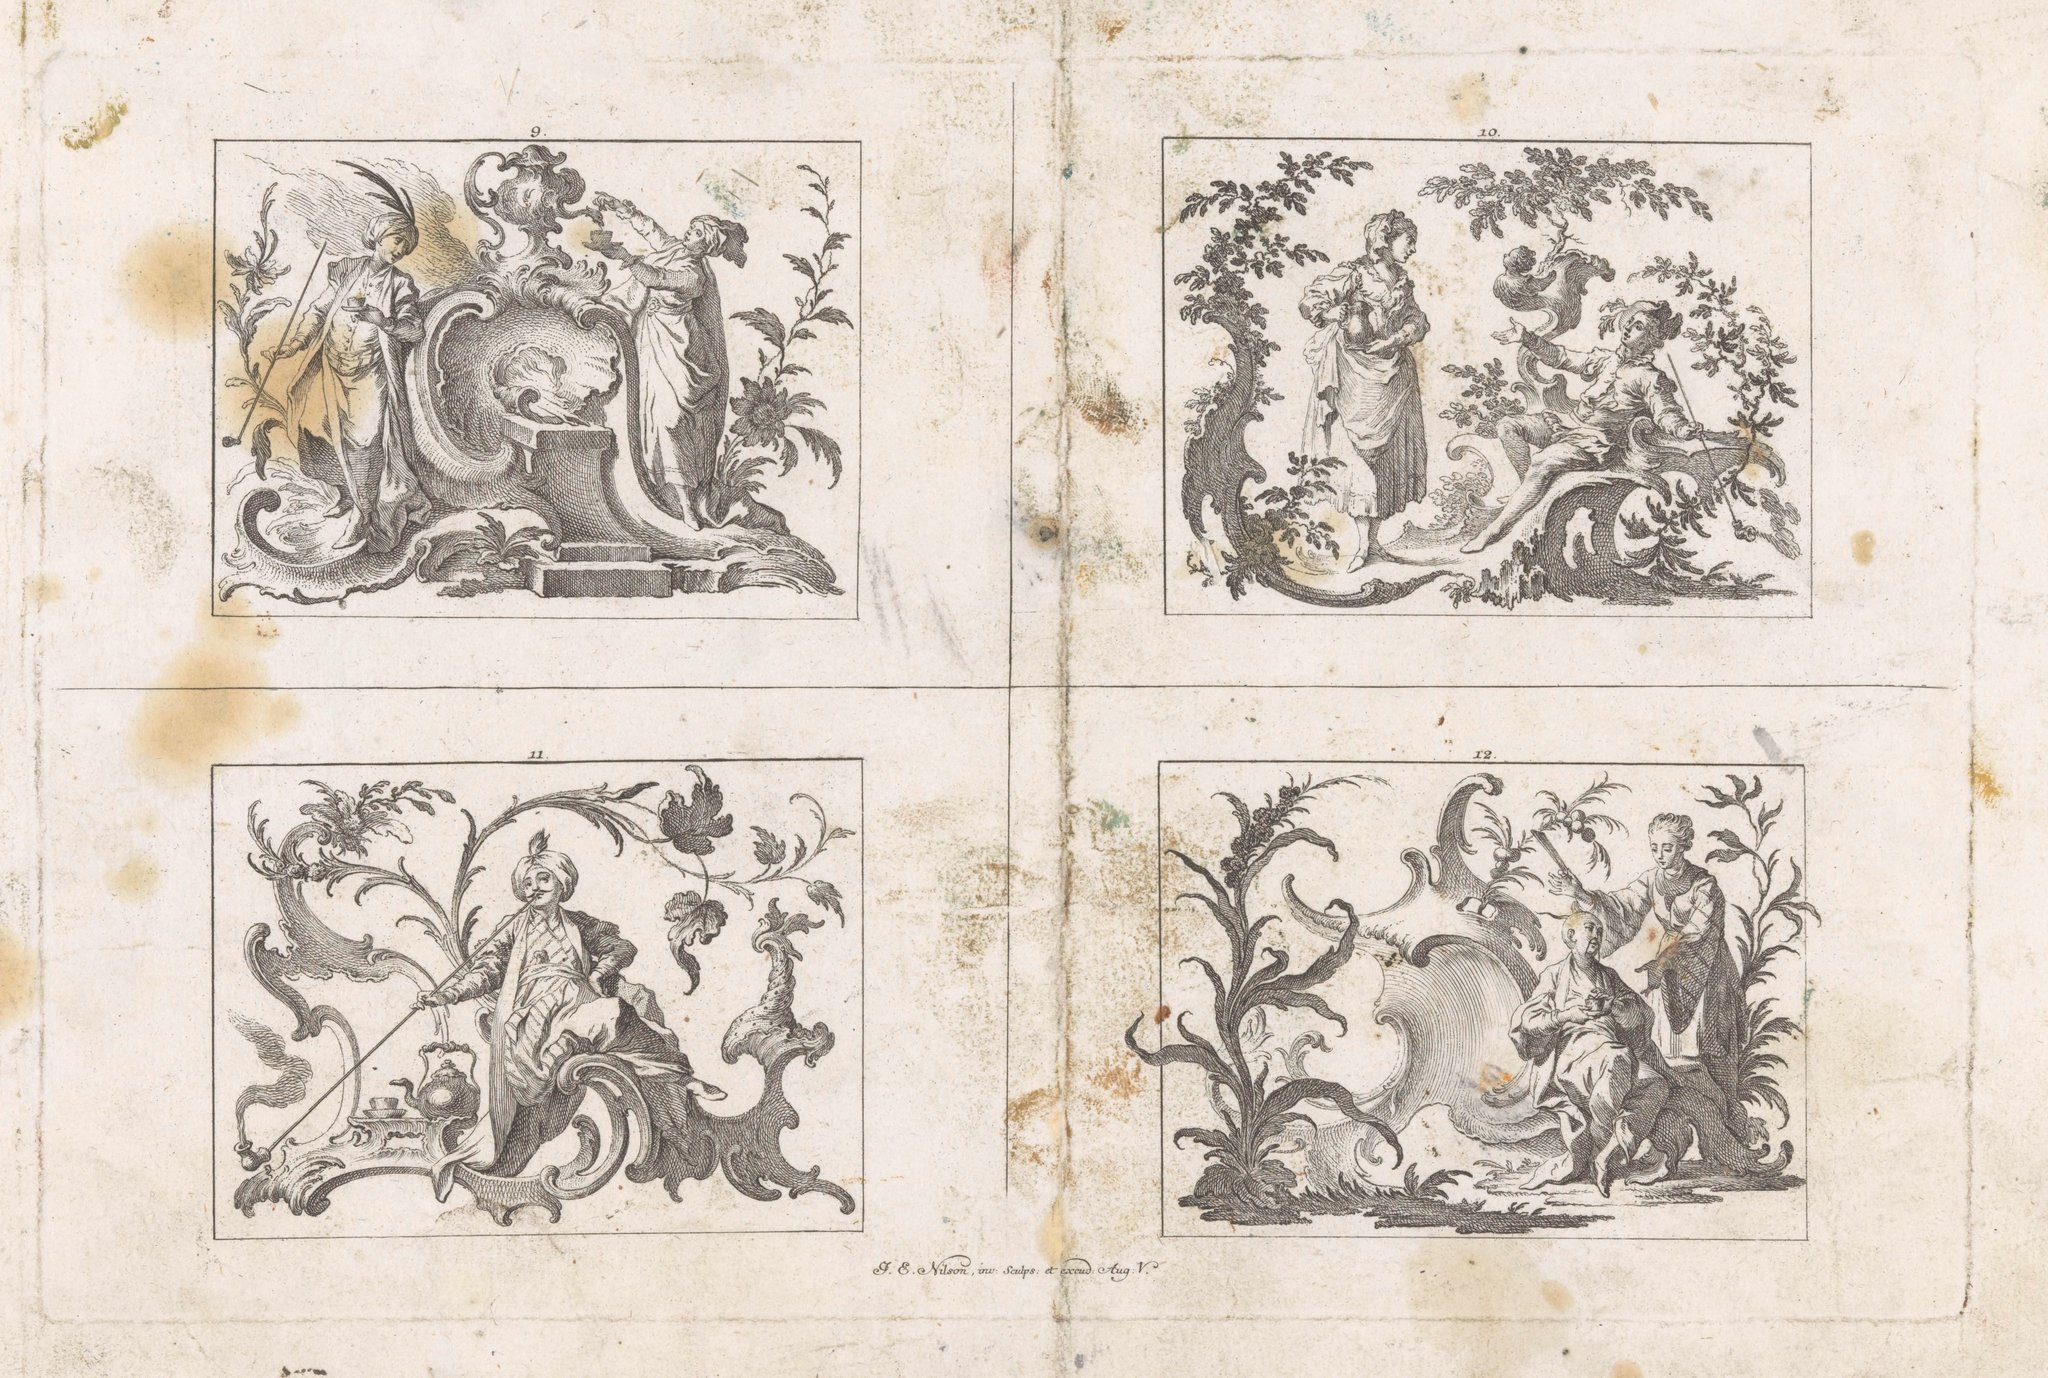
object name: print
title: Caffe The und Tobac Zierathen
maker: johann esaias nilson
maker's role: draughtsman, print maker, publisher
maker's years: 1721-1788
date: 1731-1788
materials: paper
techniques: engraving, etching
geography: augsburg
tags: pipe ~ tobacco (+ taking (particular) foodstuffs: eating, drinking, smoking, chewing, etc.)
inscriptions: collector's mark: Lugt 2228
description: Vier scènes op een blad, genummerd 9-12. Linksboven een man met een pijp naast een kwabornament. De vrouw aan de andere kant vult een kopje. Rechtsboven een vrouw met een kan voor een man met een pijp. Linksonder rookt een man met tulband een lange pijp. Rechtsonder een Aziatische man met kop-en-schotel naast een vrouw.